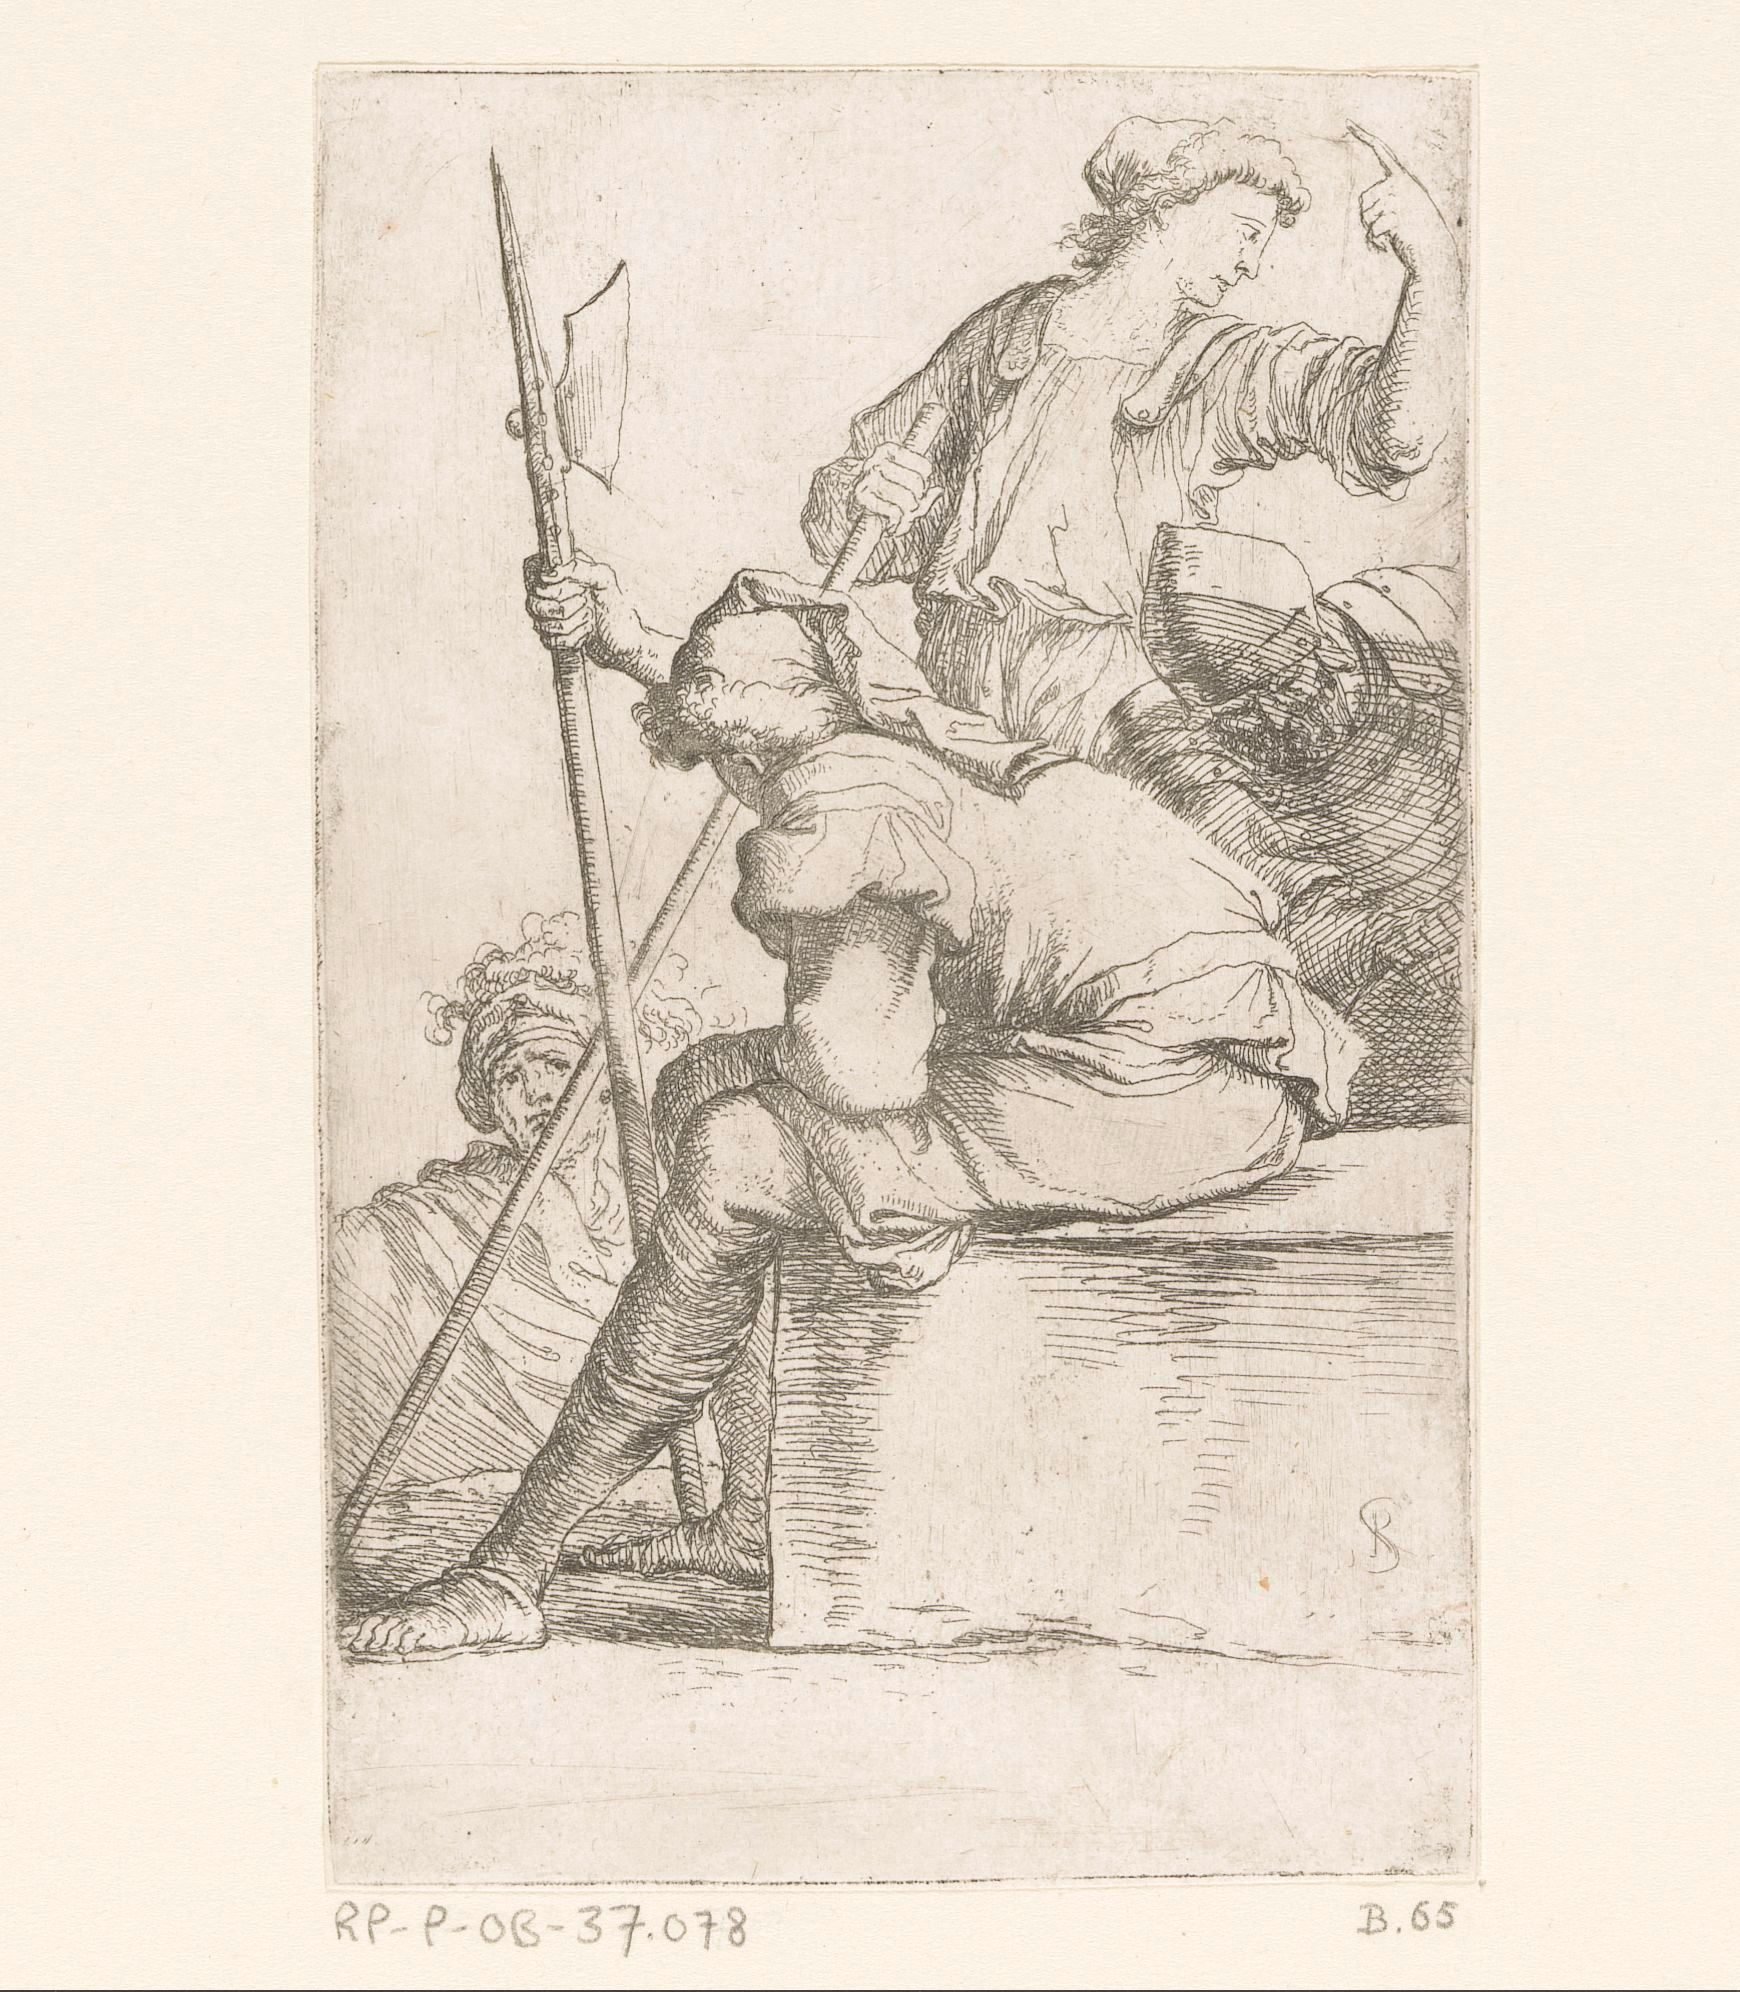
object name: print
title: Vier soldaten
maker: salvator rosa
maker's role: draughtsman, painter, print maker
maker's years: 1615-1673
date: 1656-1657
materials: paper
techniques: drypoint, etching, intaglio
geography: italy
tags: the soldier; the soldier's life, helved weapons, polearms (for striking, hacking, thrusting): halberd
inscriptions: collector's mark: Lugt 240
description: Prent naar een tekening die zich eens bevond in de collectie van Ladislao Odescalchi te Rome. De tekening werd in 1976 geveild te Londen. Deze prent maakt deel uit van de serie 'Figurine', bestaande uit een titelprent en 80 prenten van klein formaat met voorstellingen van mannelijke en vrouwelijke figuren. Rosa produceerde de serie waarschijnlijk gedurende de jaren 1656 en 1657.